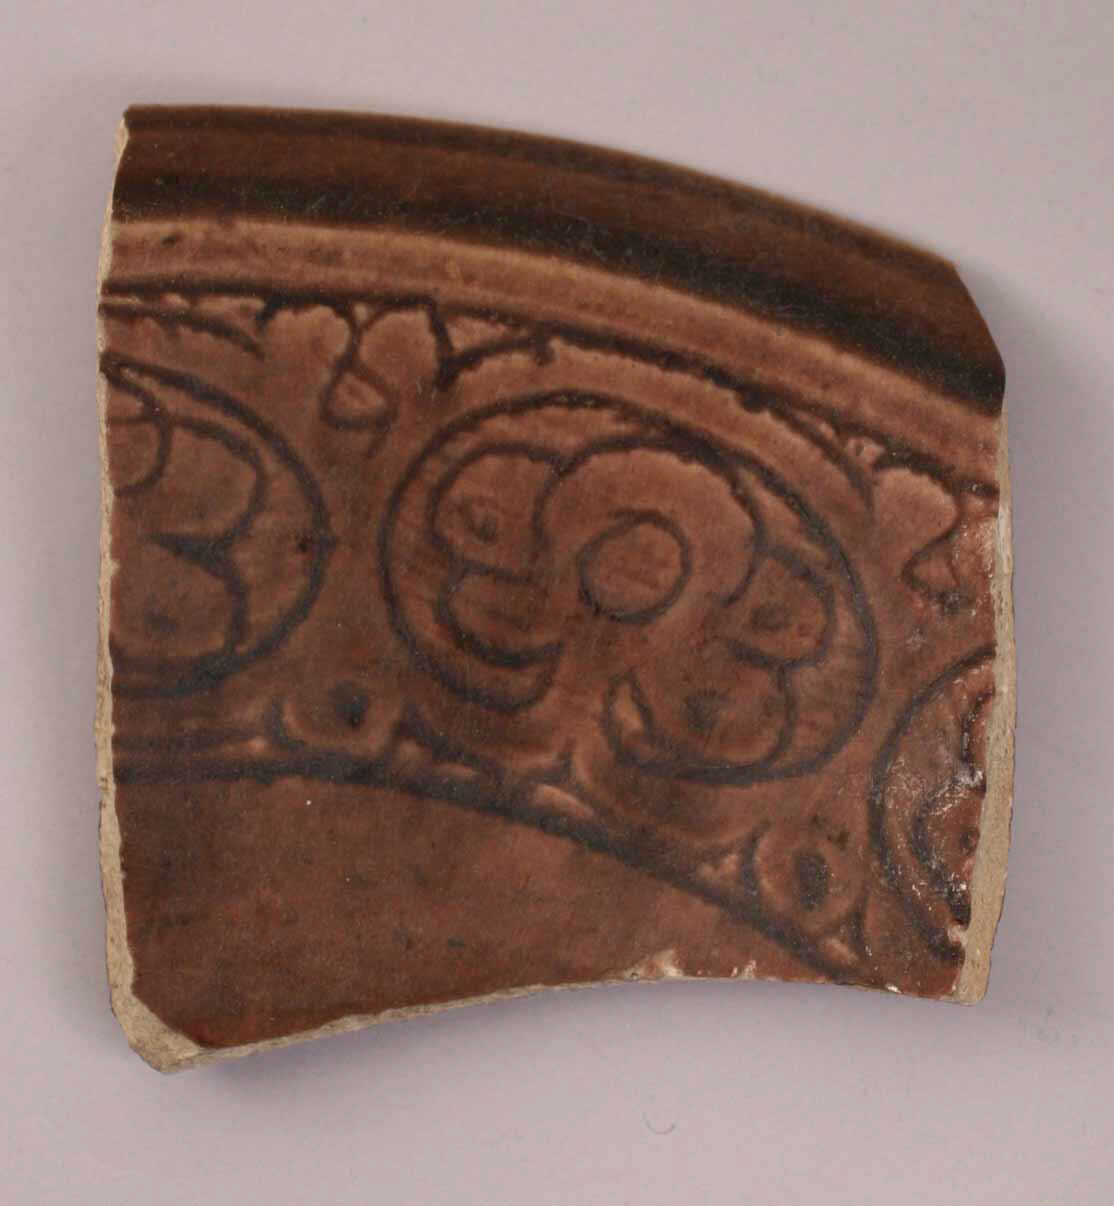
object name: ceramic fragment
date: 1201-1400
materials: stonepaste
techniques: glazing, incising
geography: egypt